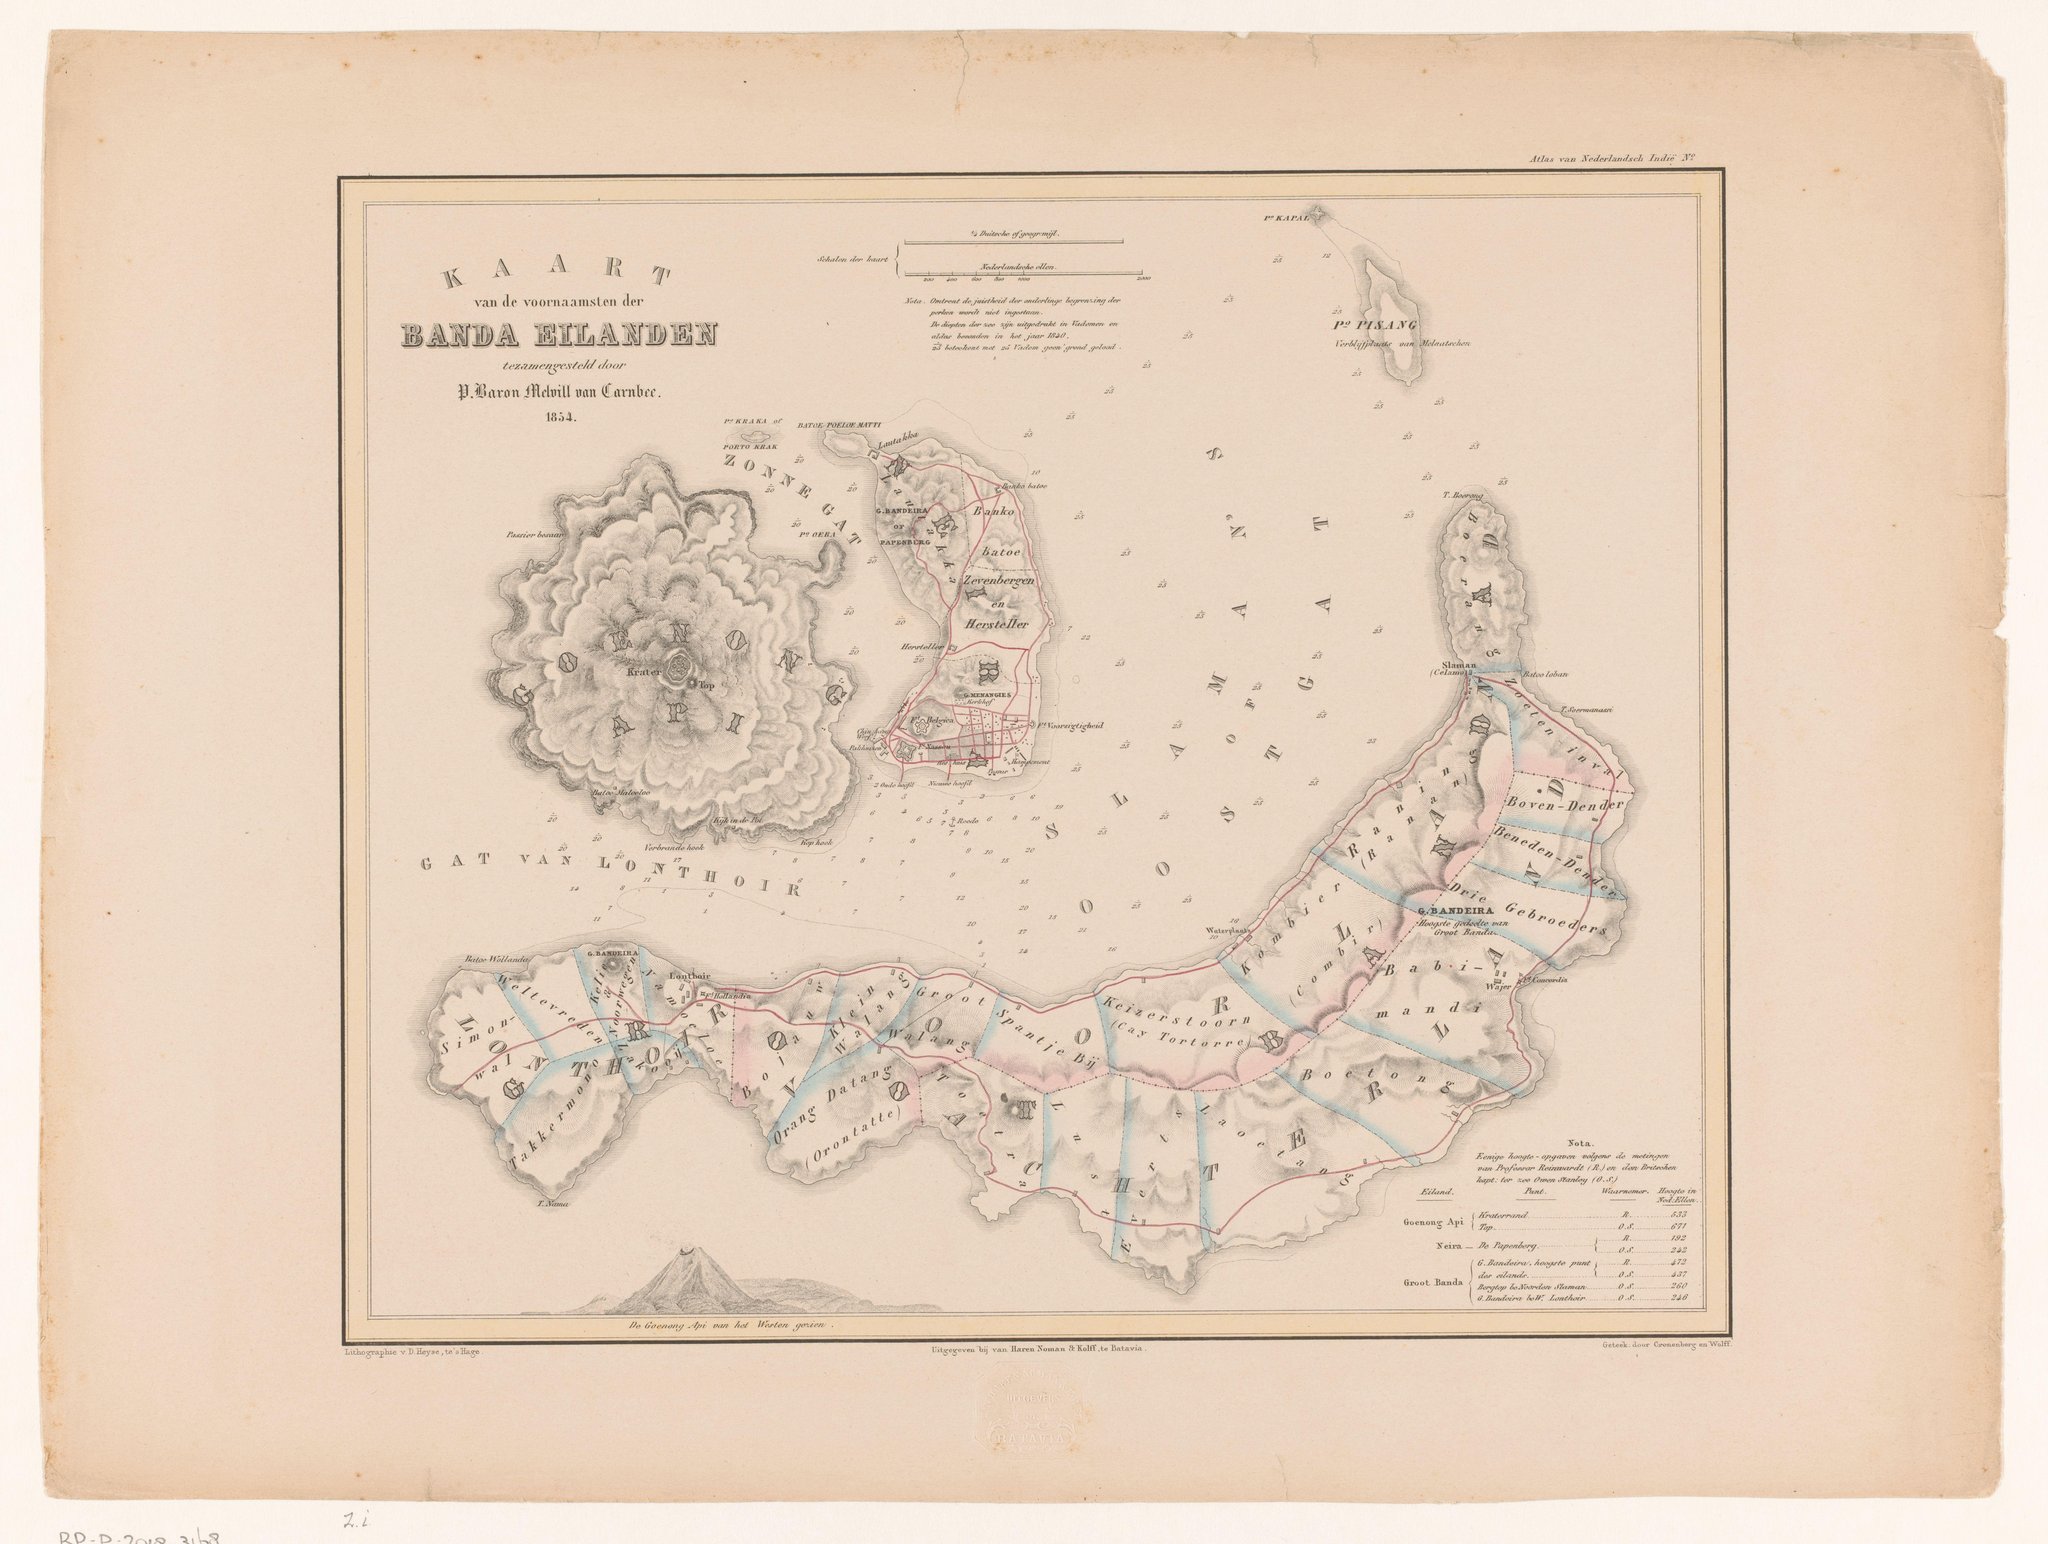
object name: map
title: Kaart van de Banda-eilanden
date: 1854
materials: paper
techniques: lithograph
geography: the hague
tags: marine charts, island (in tropical and sub-tropical regions)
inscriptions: collector's mark: Lugt 2228, check stamp: ‘Van Haren Noman & Kolff uitgevers te Batavia’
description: Kaart met daarop de eilanden Banda Besar (hier Groot Banda genoemd), Bandaneira, Banda Api, evenals de kleinere eilanden Pulau Pisang, Batu Kapal en Pulau Kerapa. In de onderzijde van de prent is een profiel van het vulkaaneiland Banda Api afgebeeld. Midden bovenin twee schaalstokken en rechts onderin een tabel met hoogtemetingen.